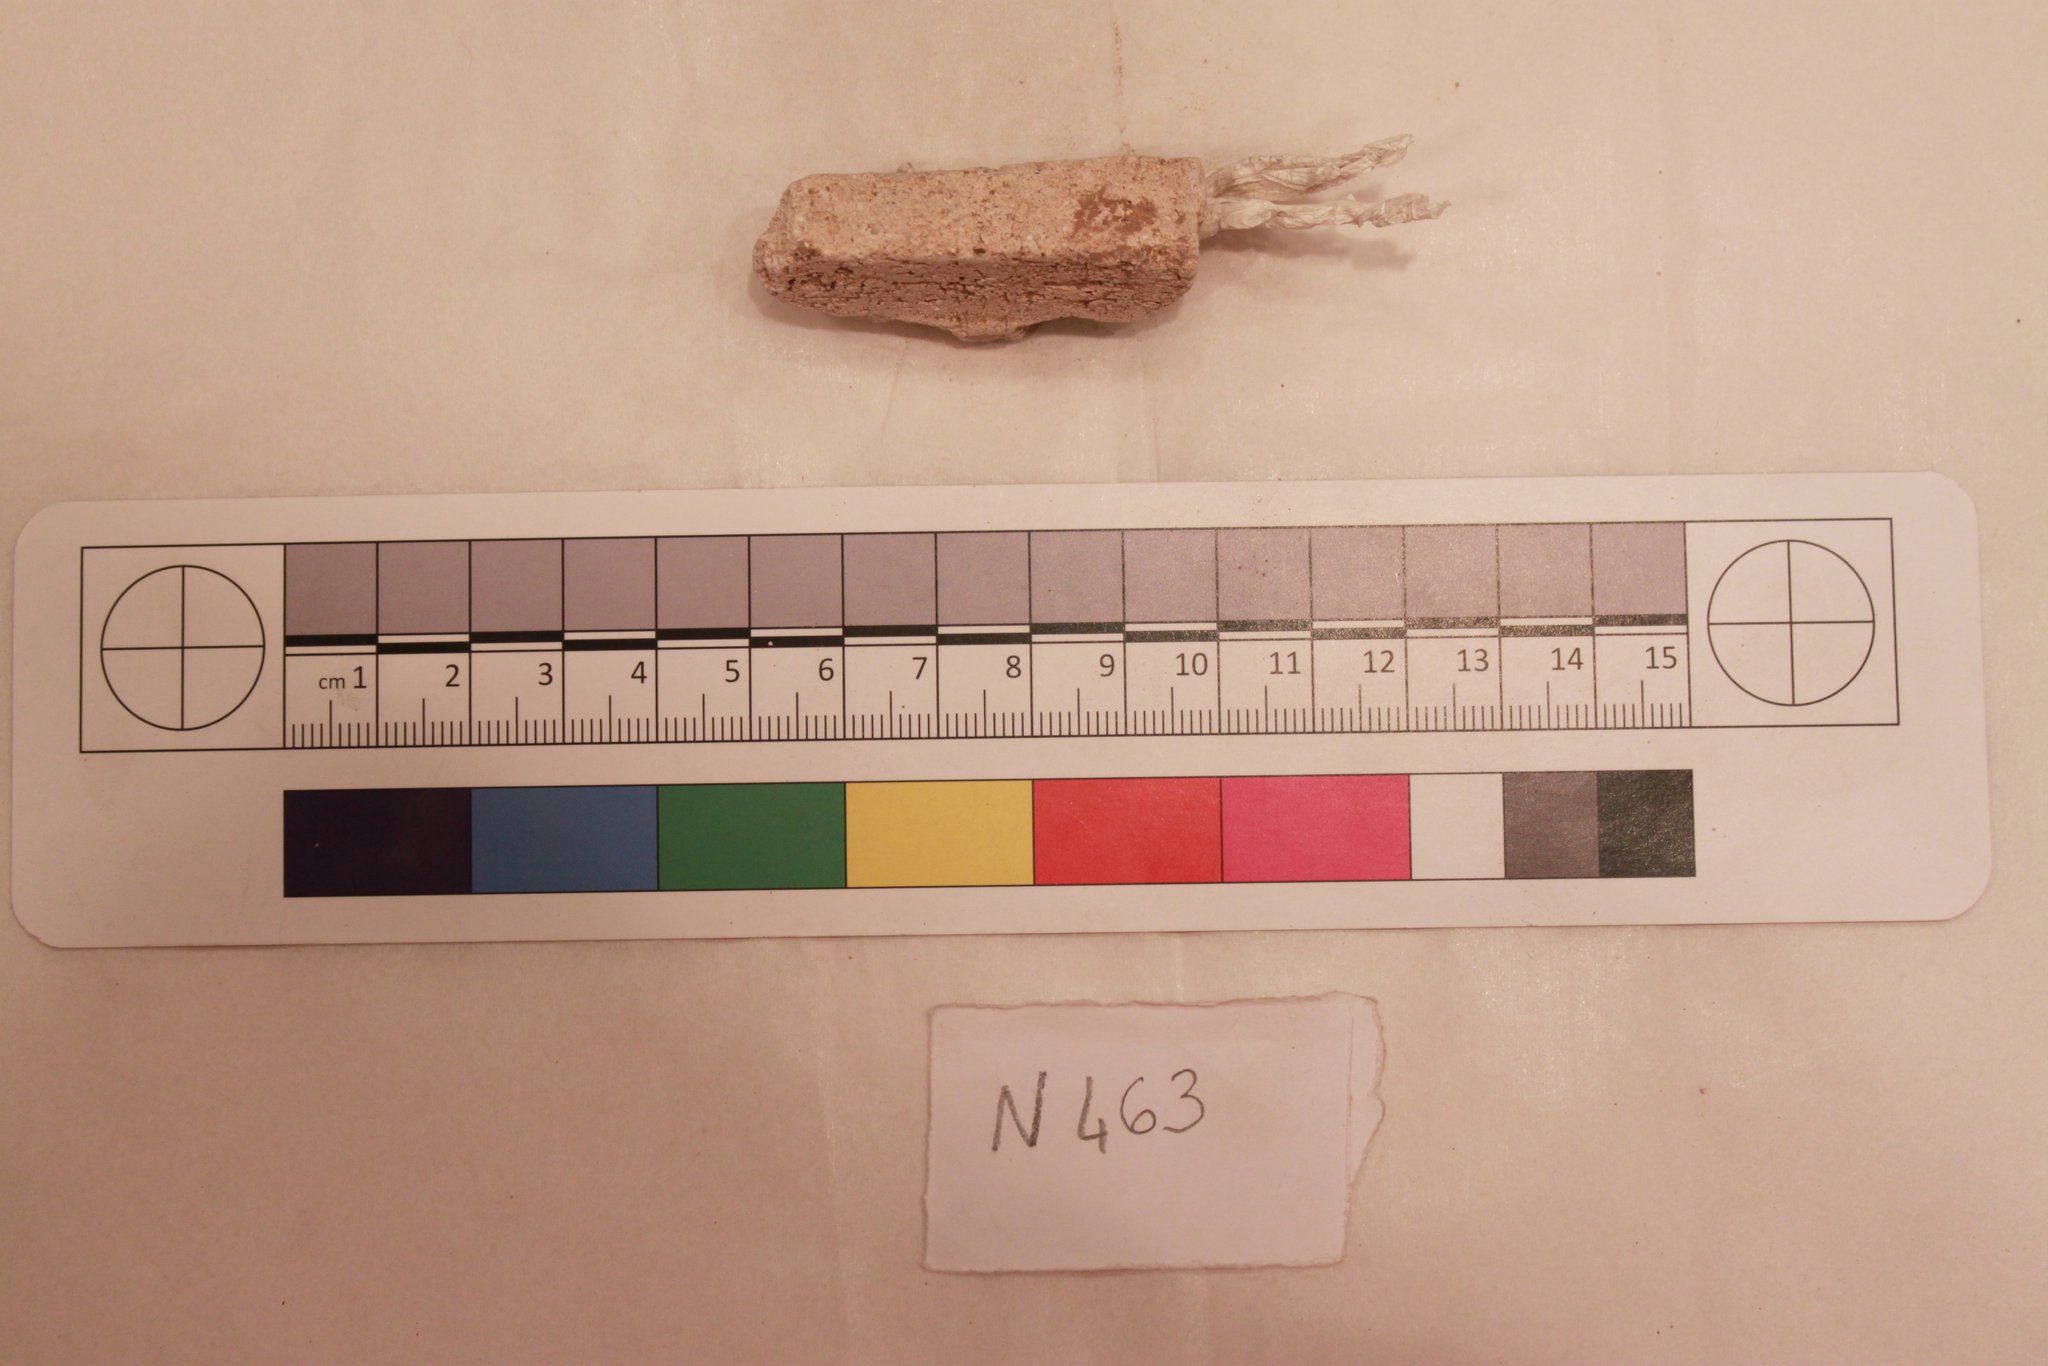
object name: fragment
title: Stucco Fragment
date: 701-1200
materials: plaster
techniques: carving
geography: iran